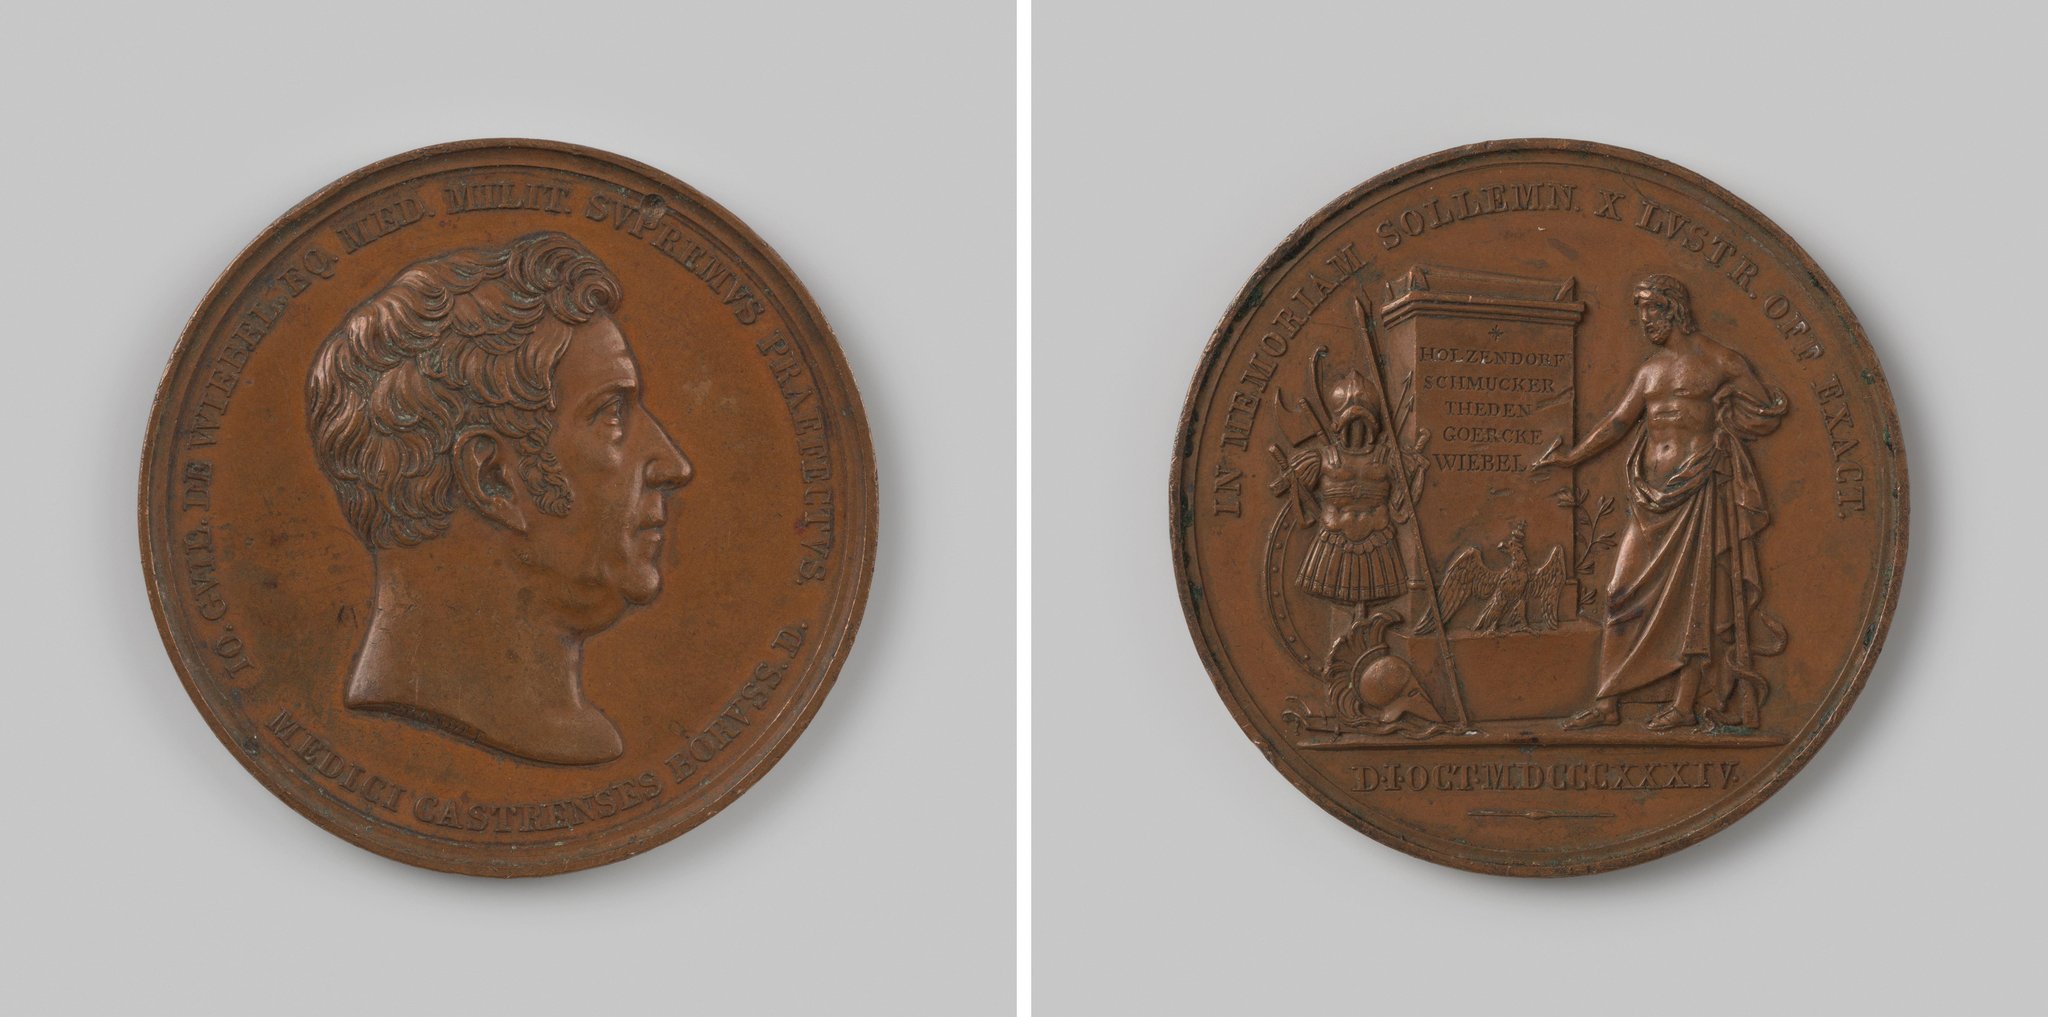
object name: history medal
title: Joh. W. Wiebel (1834)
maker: brandt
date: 1834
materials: copper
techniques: striking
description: Bronzen penning, op de voorzijde het portret van Wiebel naar rechts met omschrift, op de keerzijde Aesculapius schrijft Wiebels naam op een gedenksteen waartegen een militaire trofee, met omschrift en afsnedetekst.